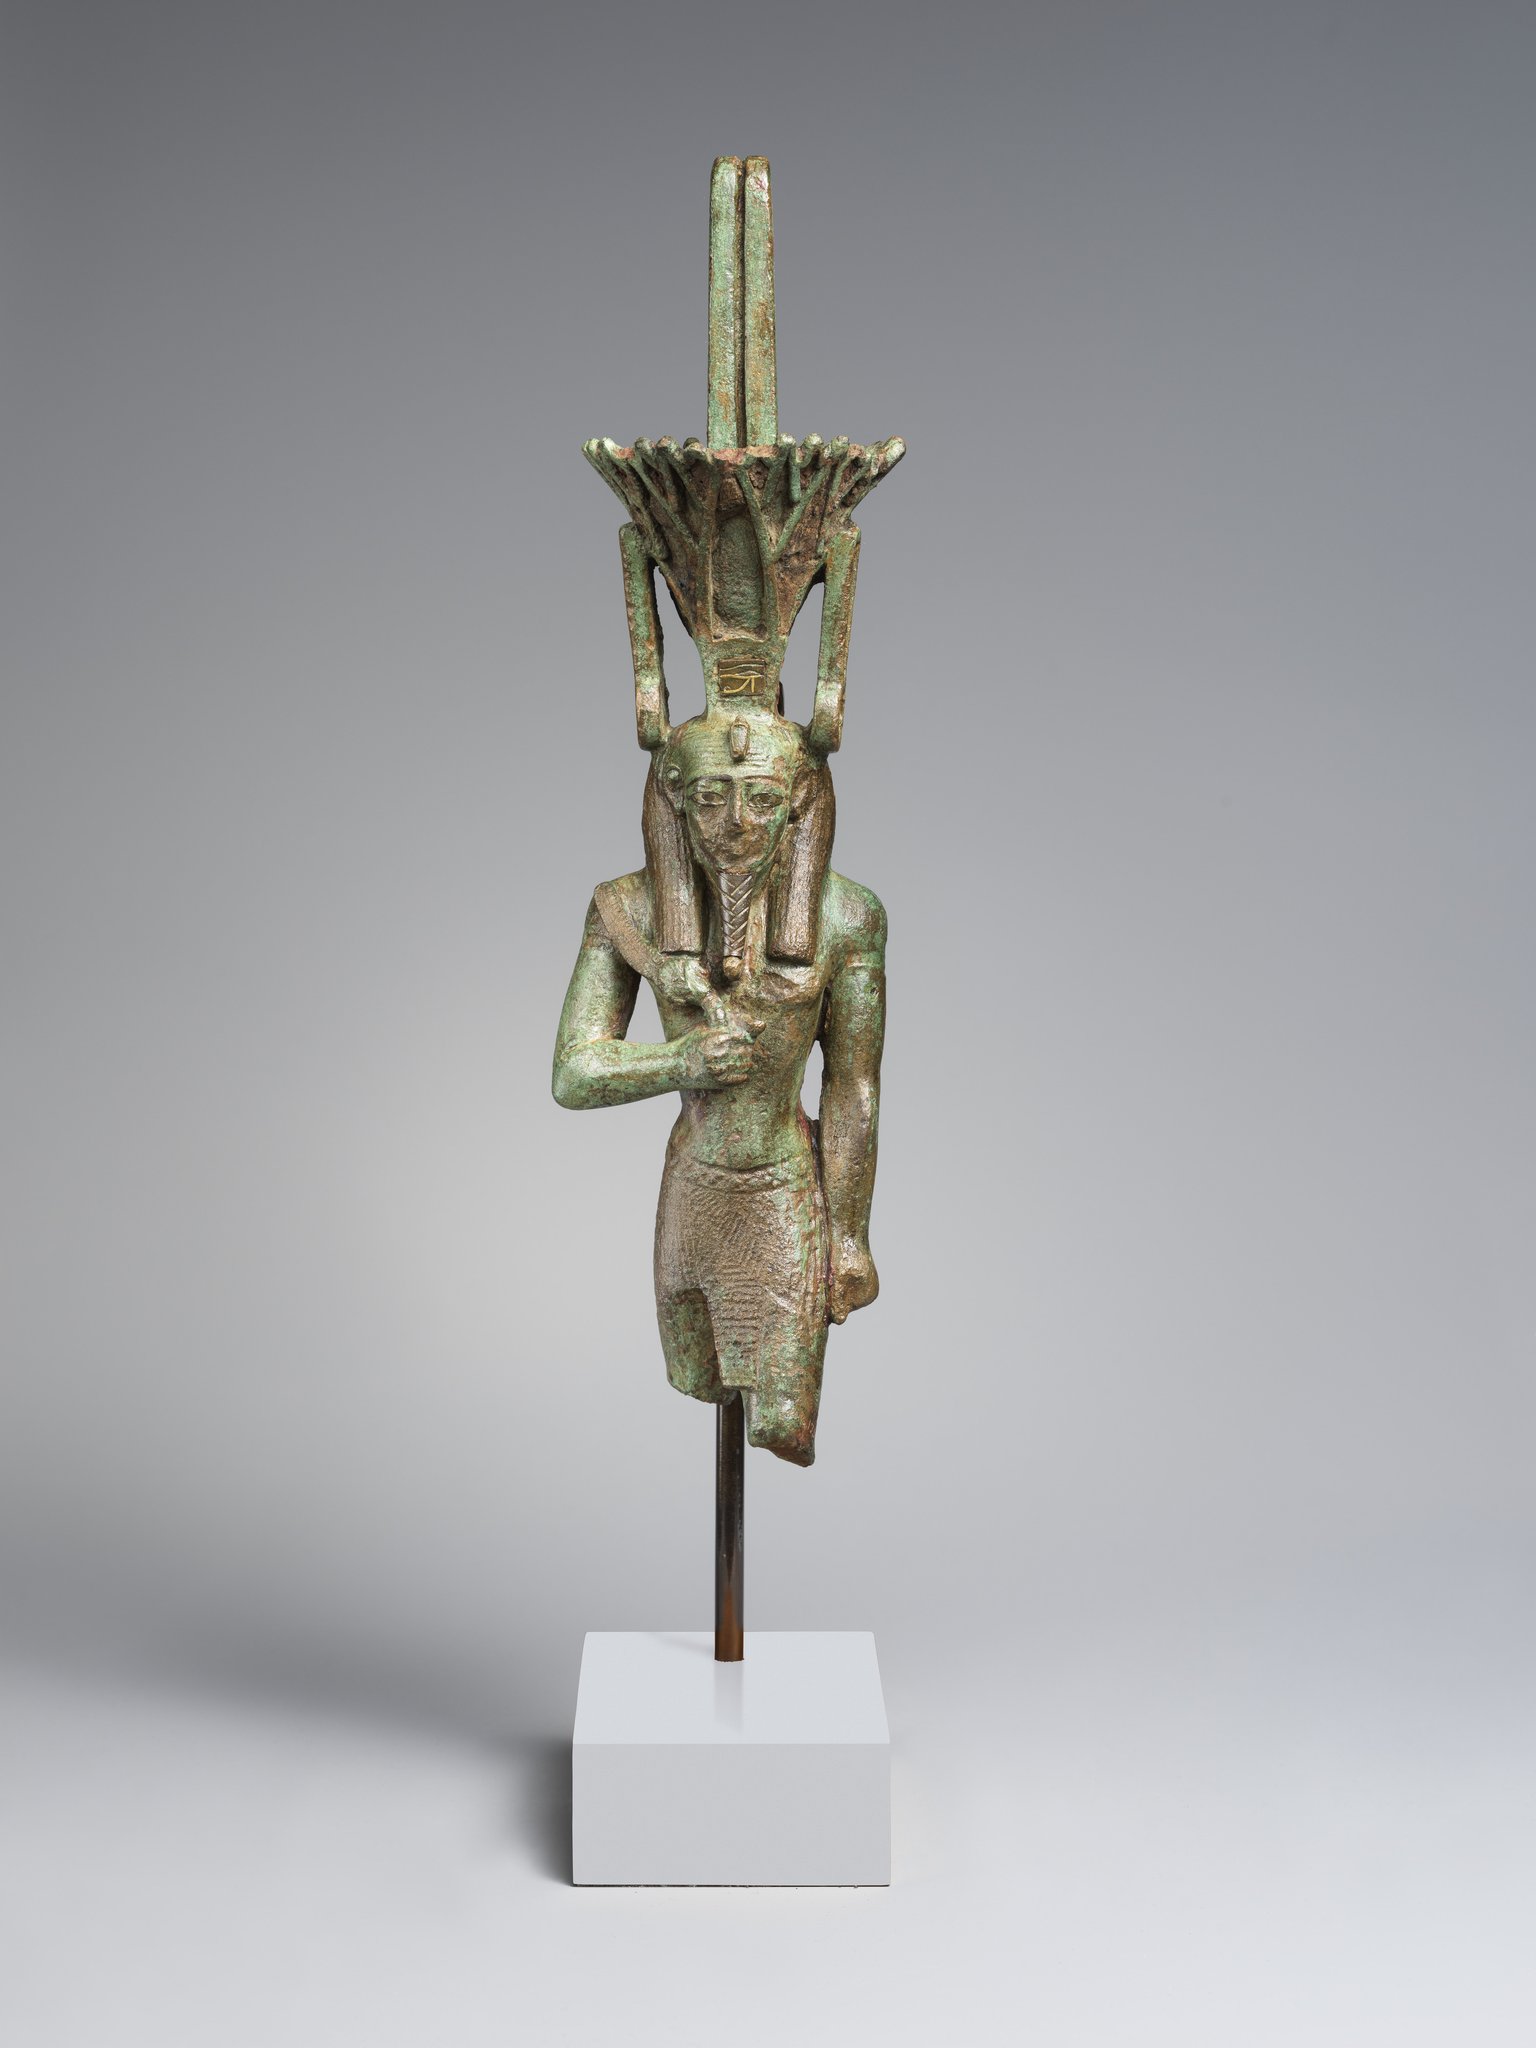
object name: statuette, nefertum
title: Nefertum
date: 664-630 BCE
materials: bronze, metal, glass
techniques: inlay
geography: egypt